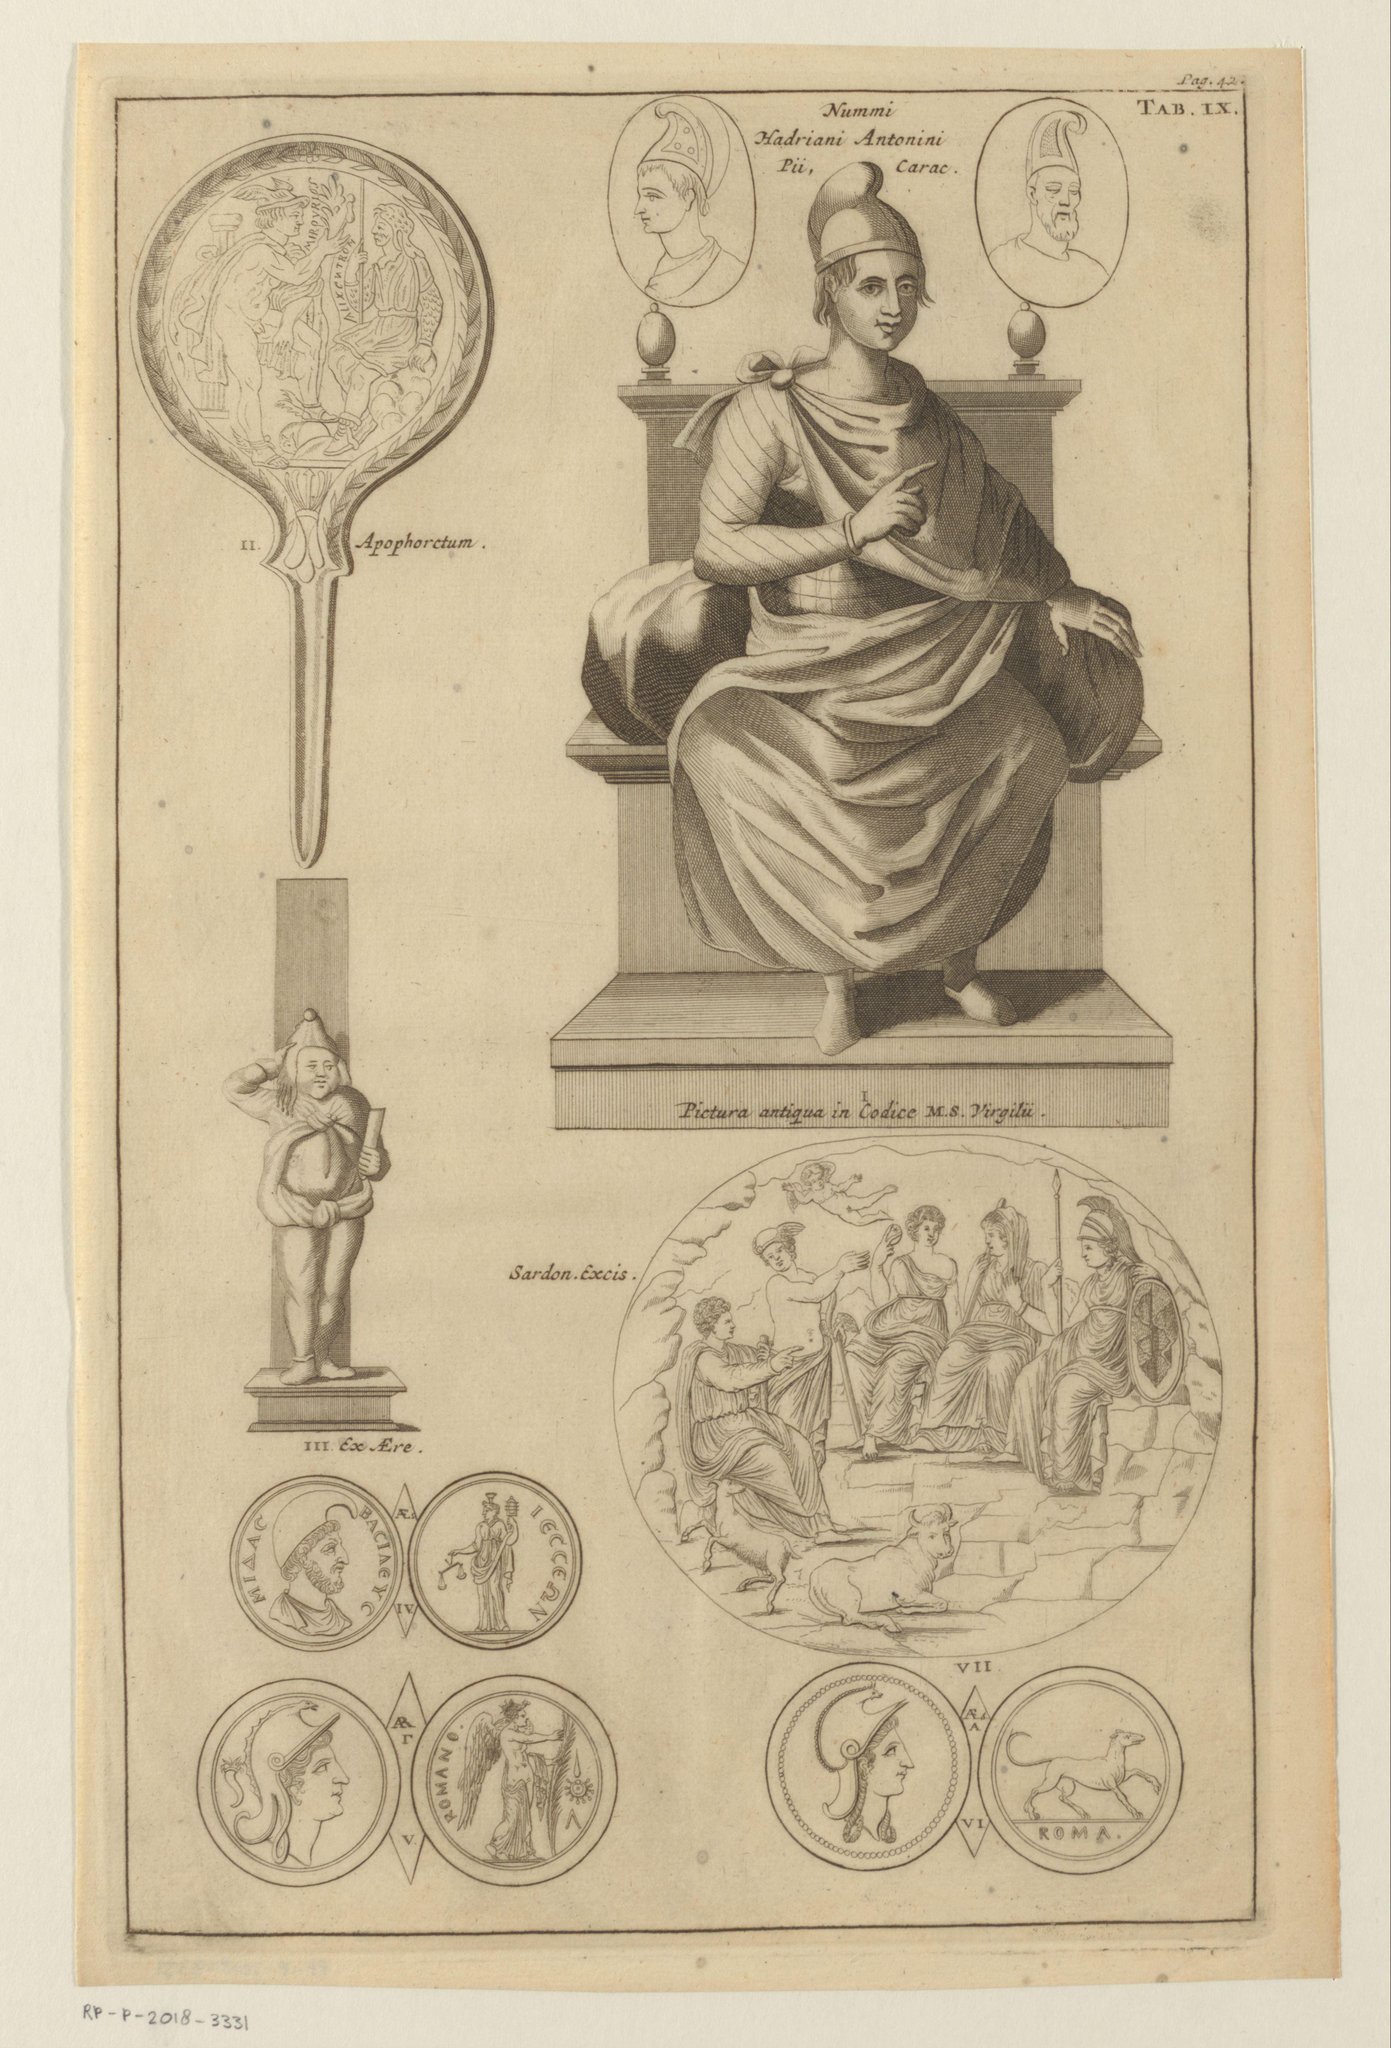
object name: print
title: Compositie met spiegel, munten, camee en een figuur uit de Vergilius Romanus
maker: Anonymous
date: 1700-1799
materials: paper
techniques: etching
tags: codex, mirror, sculpture, roman religion (including etruscan religion)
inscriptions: collector's mark: Lugt 2228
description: Prent uit een onbekend boek met objecten, kunstwerken en figuren uit de Romeinse geschiedenis en religie. Dit betreft een illustratie bij p. 42.